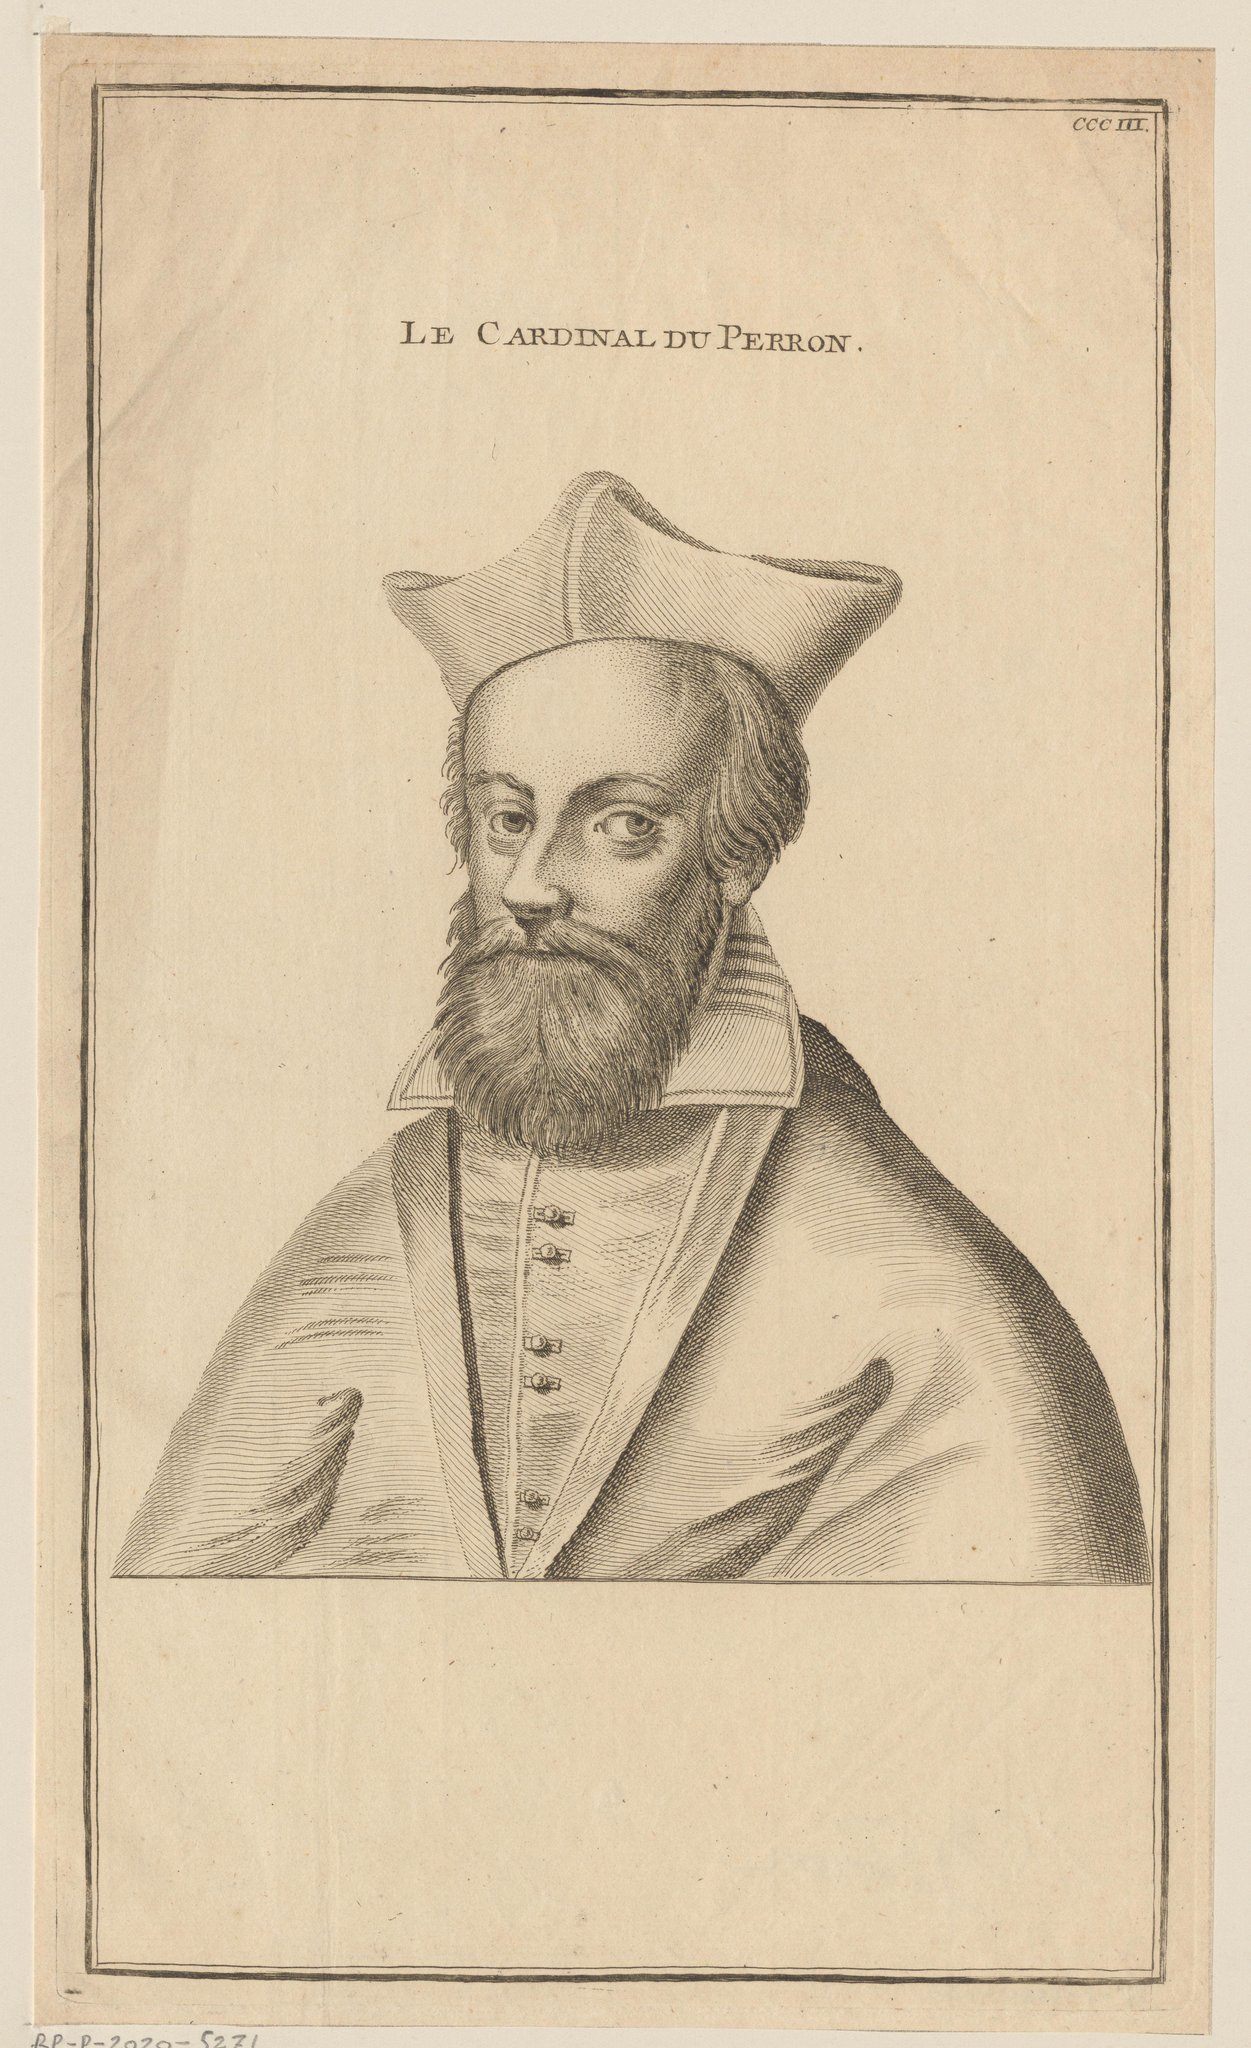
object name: print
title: Portret van Jacques Davy Duperron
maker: Anonymous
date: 1733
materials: paper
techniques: engraving, etching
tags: paris, cardinal, historical persons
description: Eerdere staat van prent gebruikt in: Monfaucon, Bernard de. Les monuments de la monarchie Françoise qui comprennent l'histoire de France (...). Parijs: Julien-Michel Gandouin en Pierre-François Giffart, 1733, dl. 5.